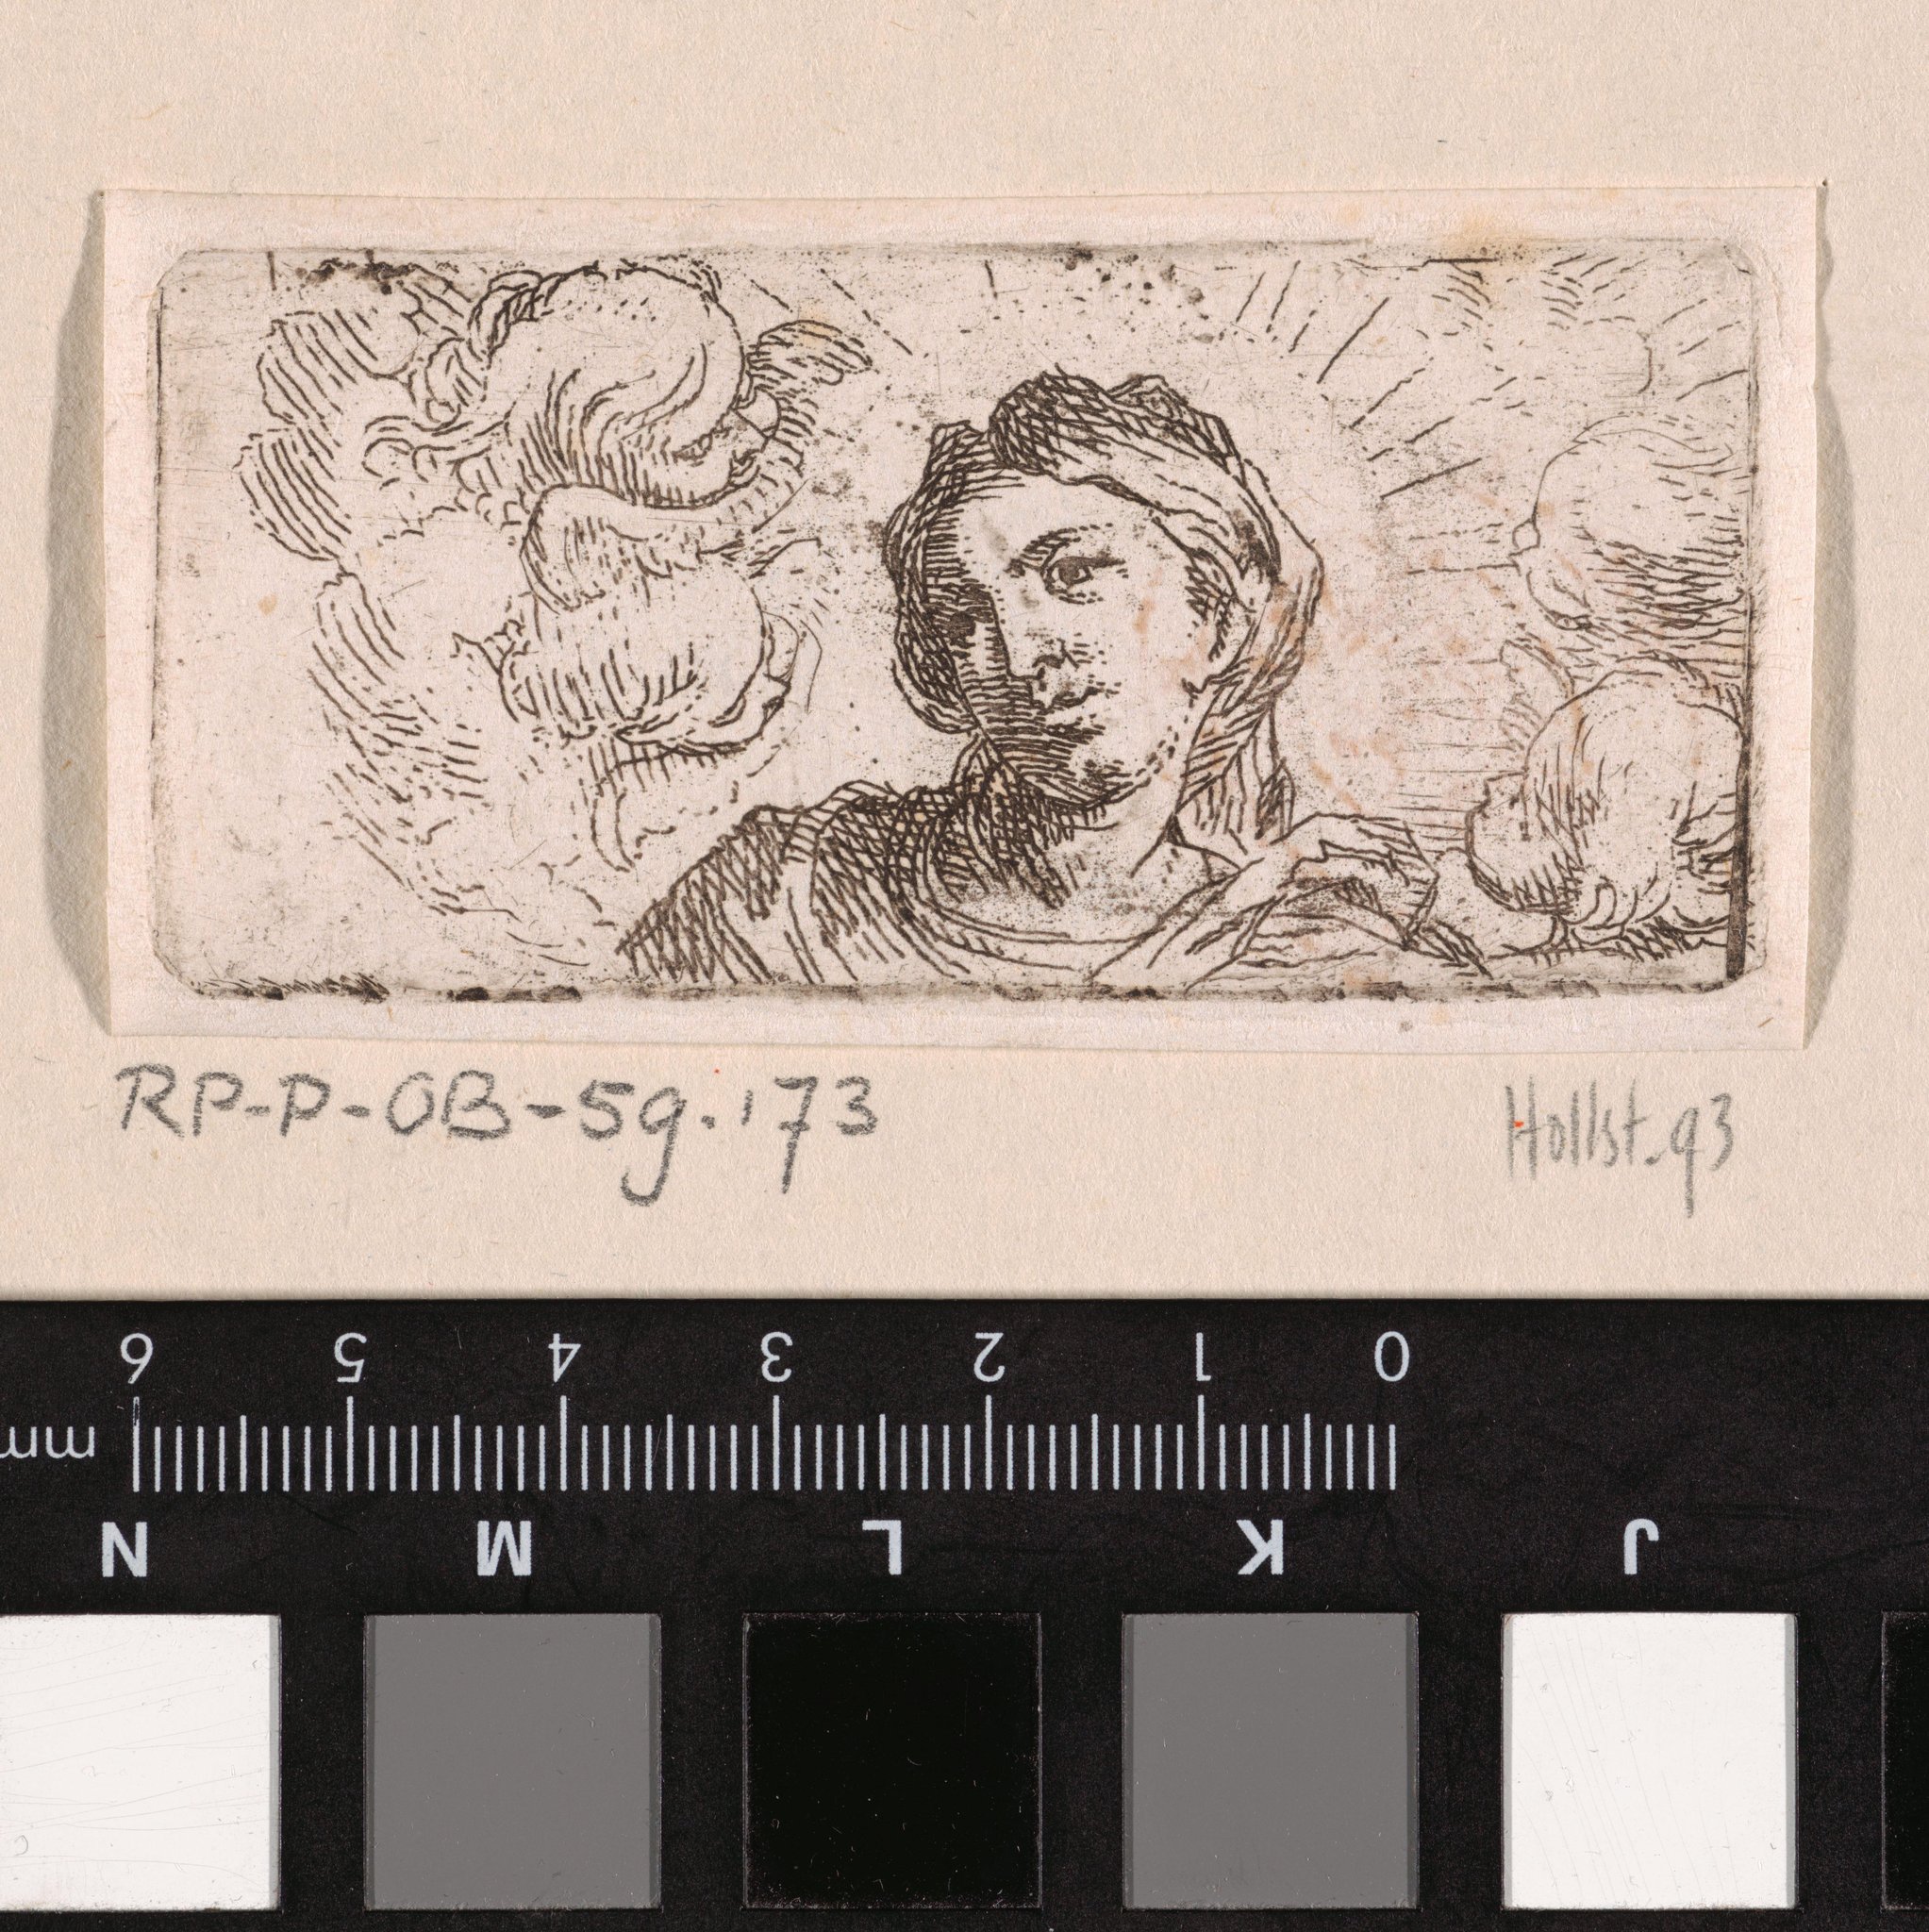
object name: print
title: Maria met vier cherubijntjes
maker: cornelis schut (i)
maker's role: draughtsman, print maker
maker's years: 1597-1655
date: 1618-1655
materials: paper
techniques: etching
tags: mary (without the christ-child)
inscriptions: collector's mark: Lugt 240